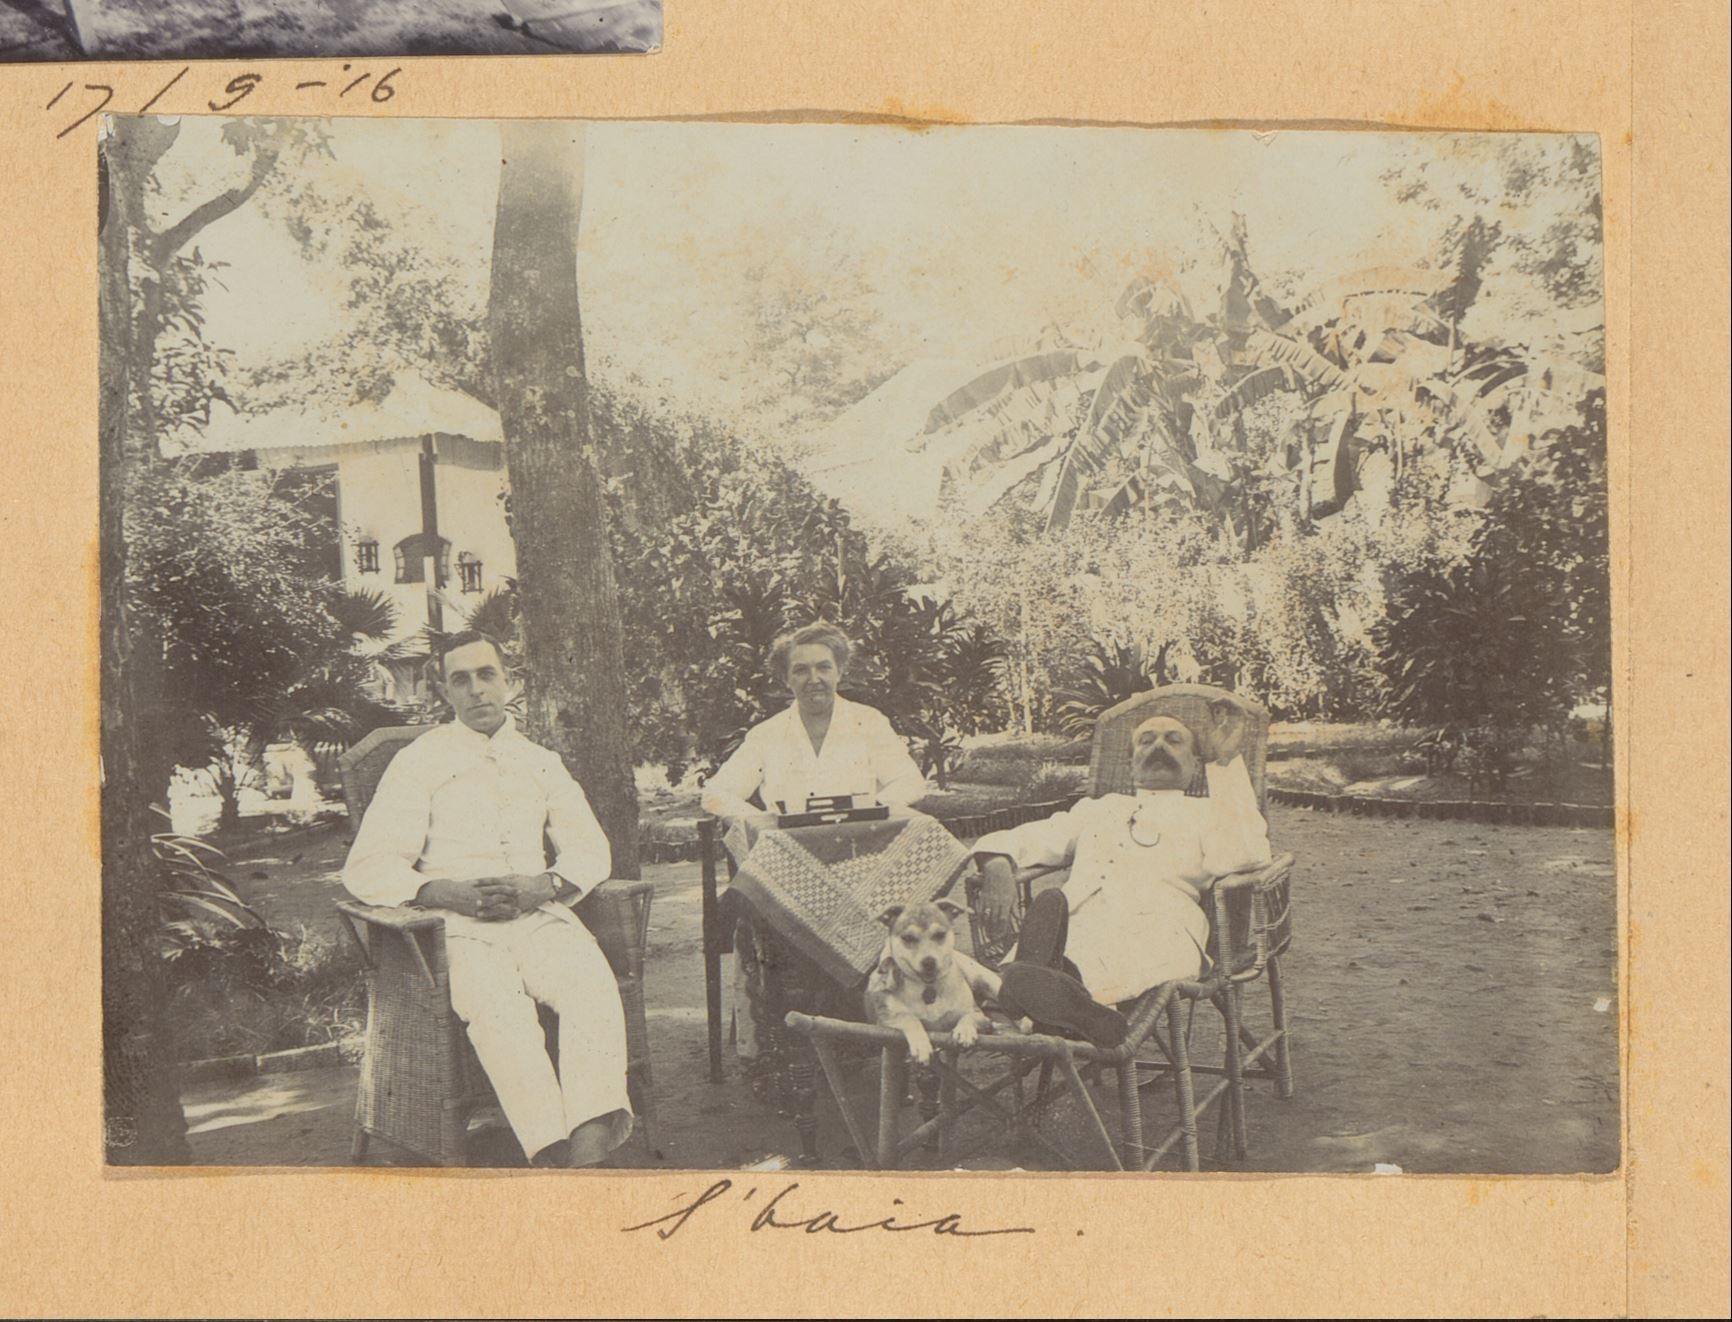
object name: photograph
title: Europese mannen en een vrouw met hond in een tuin in Soerabaja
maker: Anonymous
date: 1916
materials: photographic support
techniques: gelatin silver print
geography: surabaya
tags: adult woman, garden, adult man, surabaya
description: Onderdeel van Familiealbum met foto's van een familie in de voormalige kolonie Nederlands-Indië en van een suikerfabriek in Purworejo.